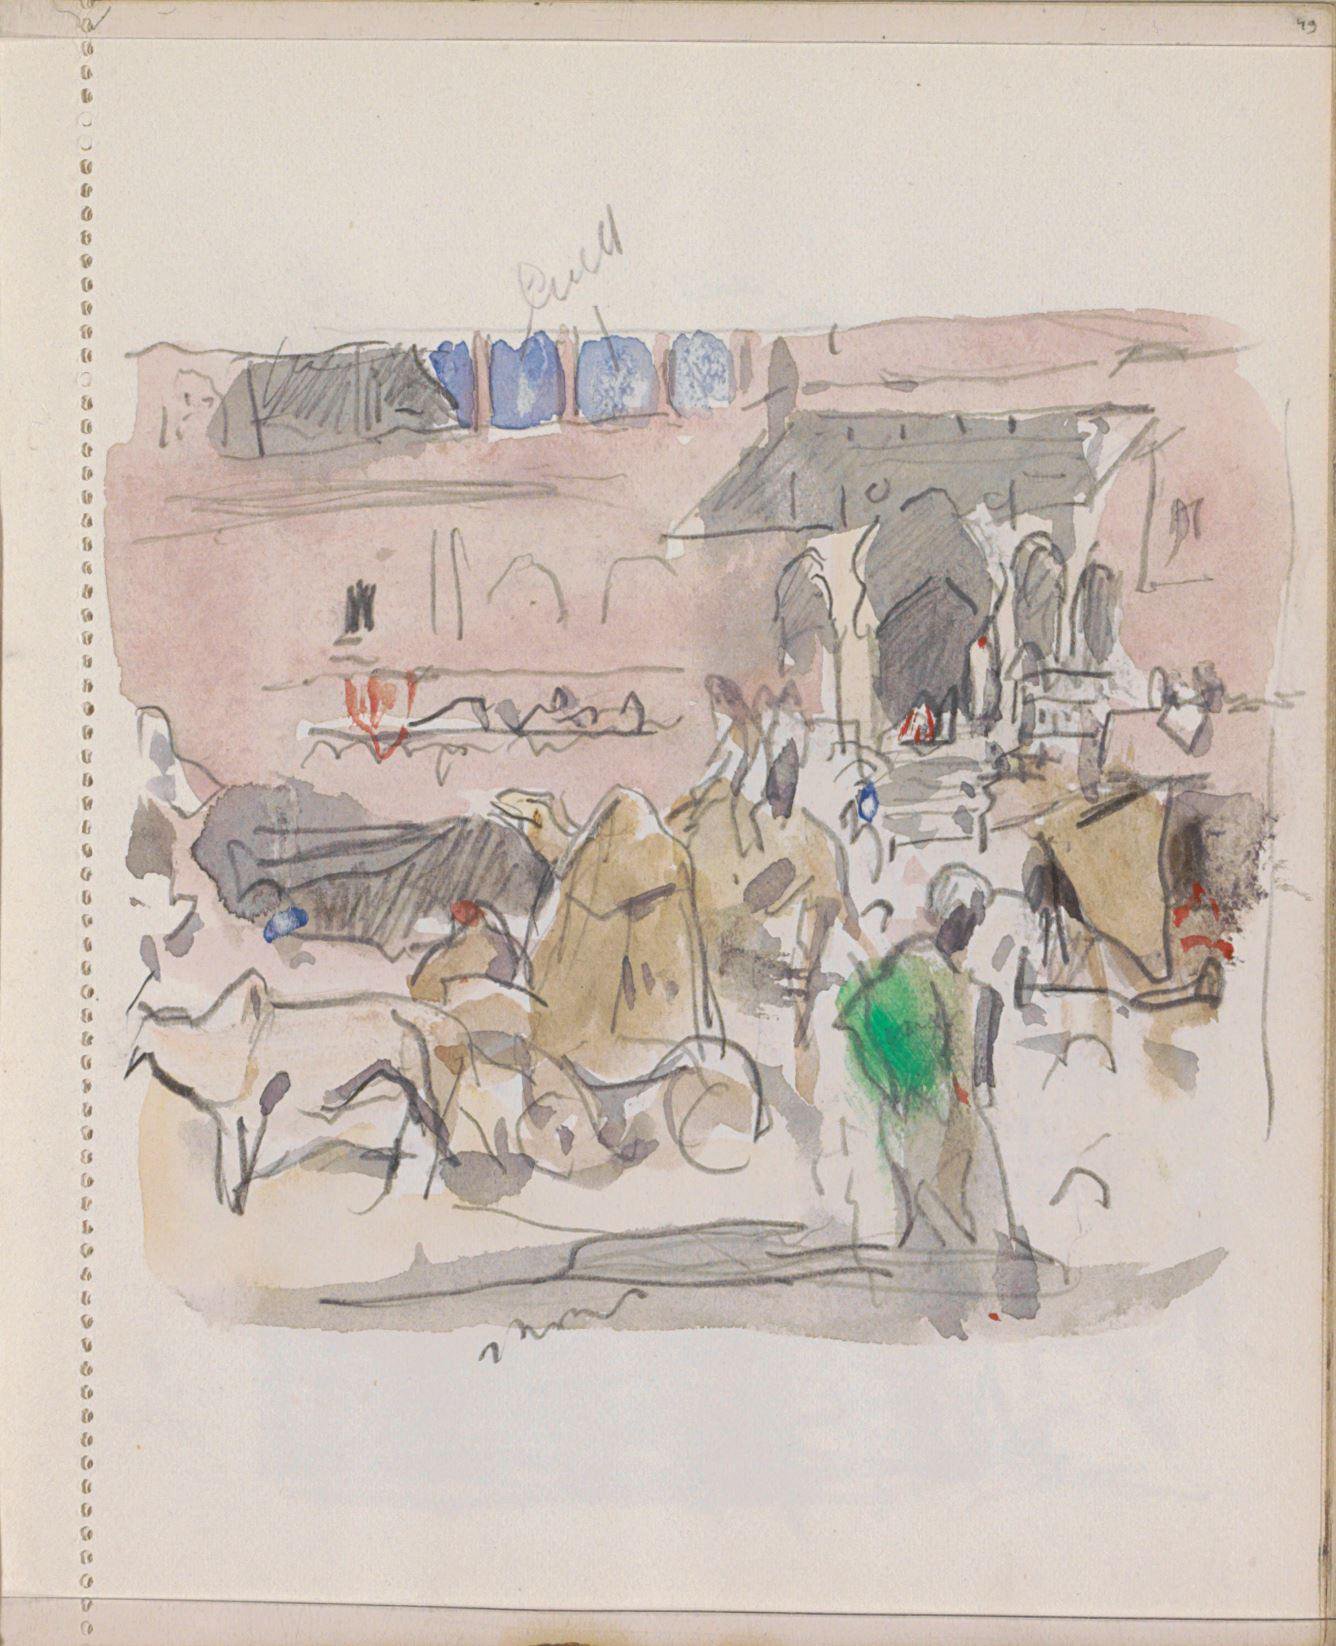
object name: sketchbook leaf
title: Straat met figuren op een kameel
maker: marius bauer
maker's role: draughtsman, print maker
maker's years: 1867-1932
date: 1924-1925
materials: paper, pencil, watercolor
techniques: brush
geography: india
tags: hoofed animals: camel, sitting figure, street (+ city(-scape) with figures, staffage)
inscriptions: kleurnotitie, handgeschreven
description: Pagina 49 uit een schetsboek met 75 bladen.